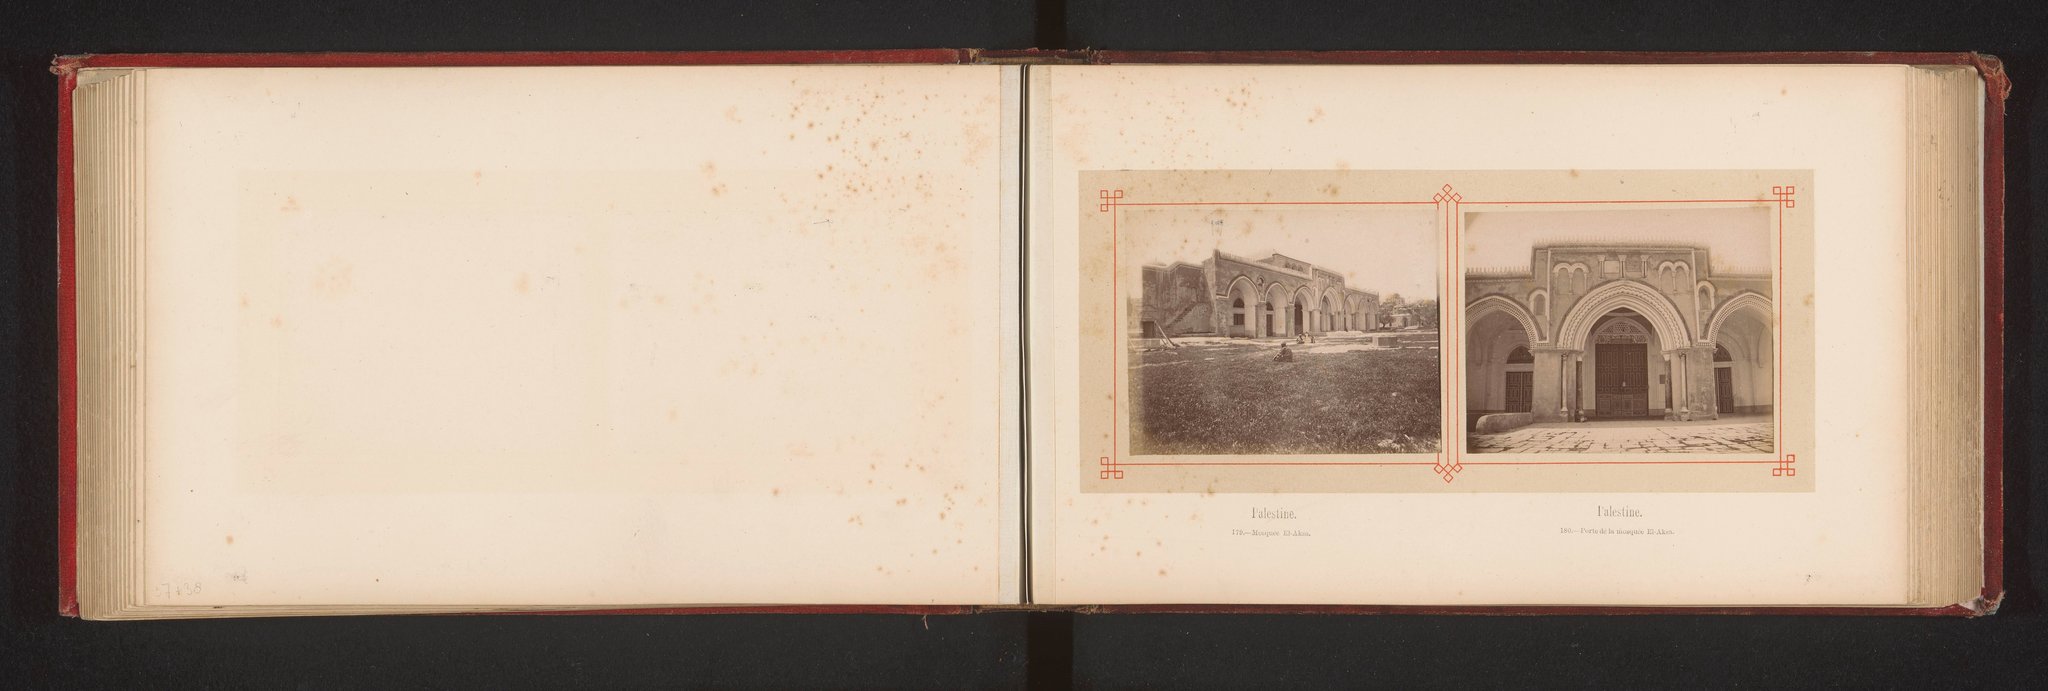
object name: photograph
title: Palestine - 180.- Porte de mosquée El-Aksa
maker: félix bonfils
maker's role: fotograaf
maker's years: 1831-1885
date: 1873-1878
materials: photographic support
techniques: albumen print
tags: gate, entrance, temple, shrine ~ islam, mohammedanism